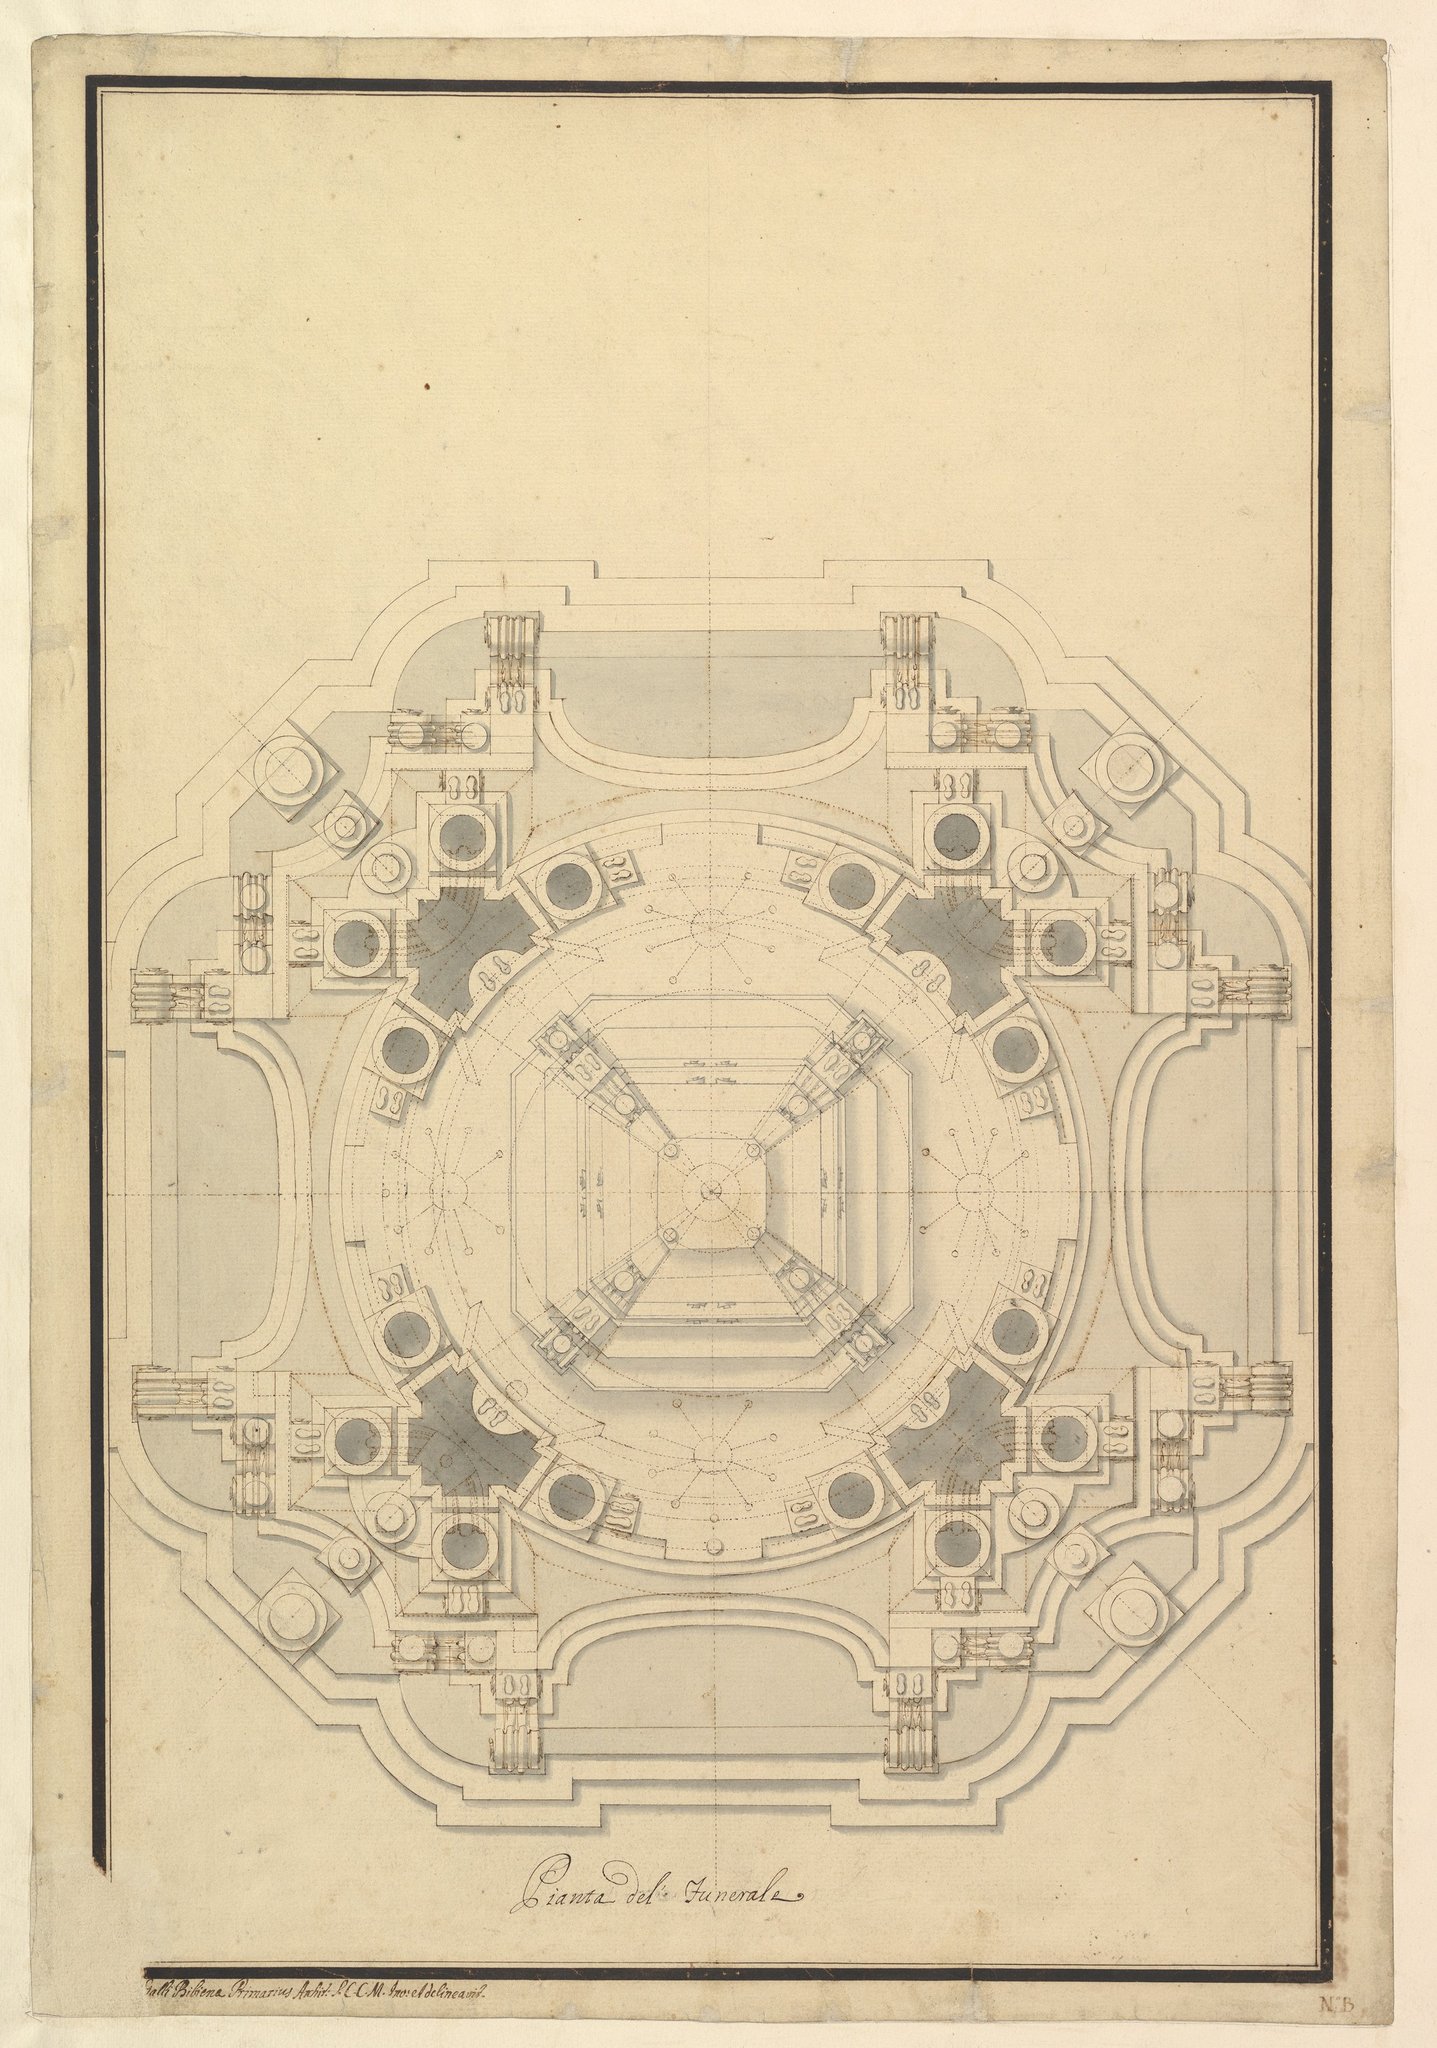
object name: drawing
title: Ground Plan for the Catafalque for Louis XIV (d. 1715)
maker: giuseppe galli bibiena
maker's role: artist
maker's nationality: italian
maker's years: 1696-1756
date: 1715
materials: ink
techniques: pen, wash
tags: architecture